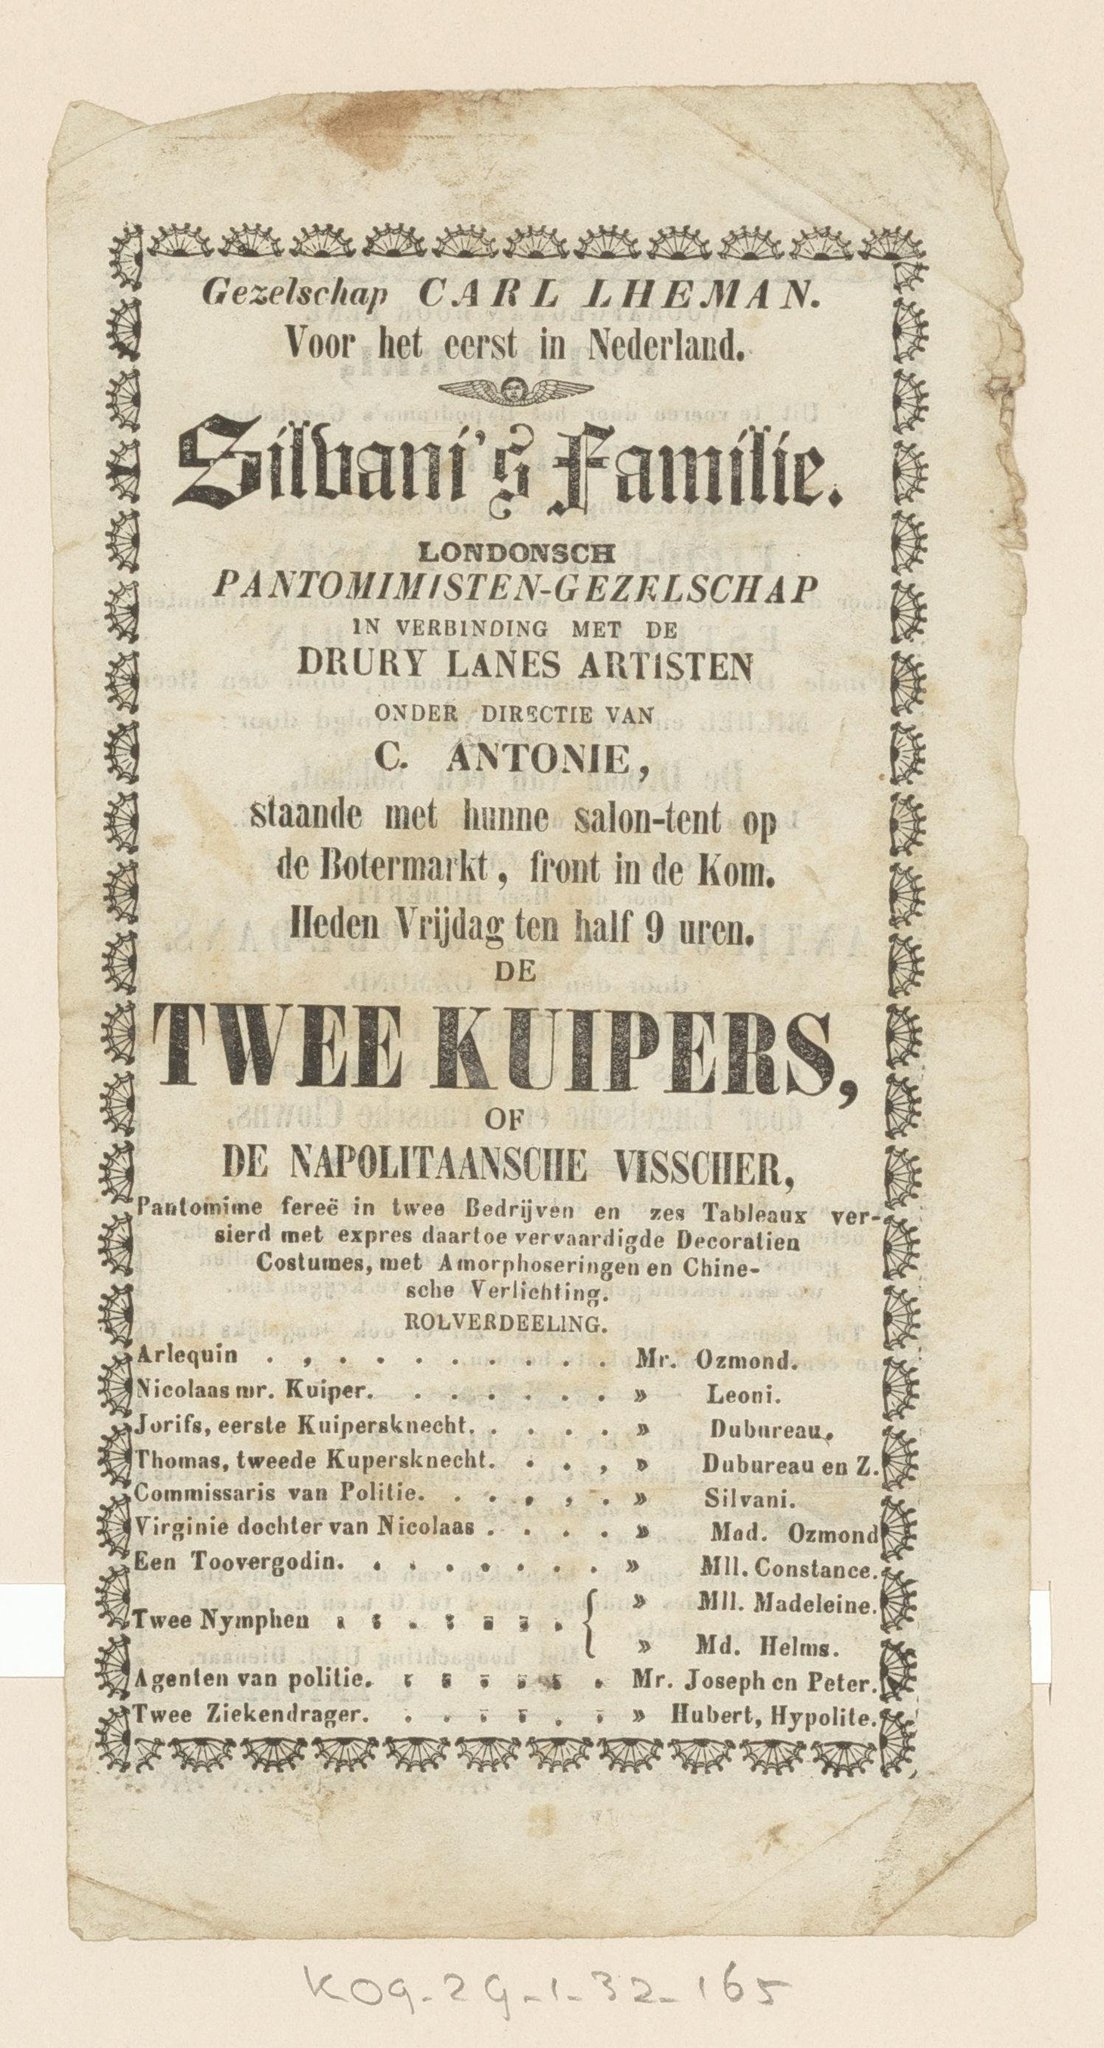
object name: programma, programmaboekje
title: Gezelschap Carl Lheman (...) Silvani's Familie. Londonsch Pantomimisten-Gezelschap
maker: alex. a. crafford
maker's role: printer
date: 1854-1856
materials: paper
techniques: letterpress printing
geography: middelburg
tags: pleasure fair and circus, pantomime, dumb show, masque, amsterdam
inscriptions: collector's mark: Lugt 1641, collector's mark